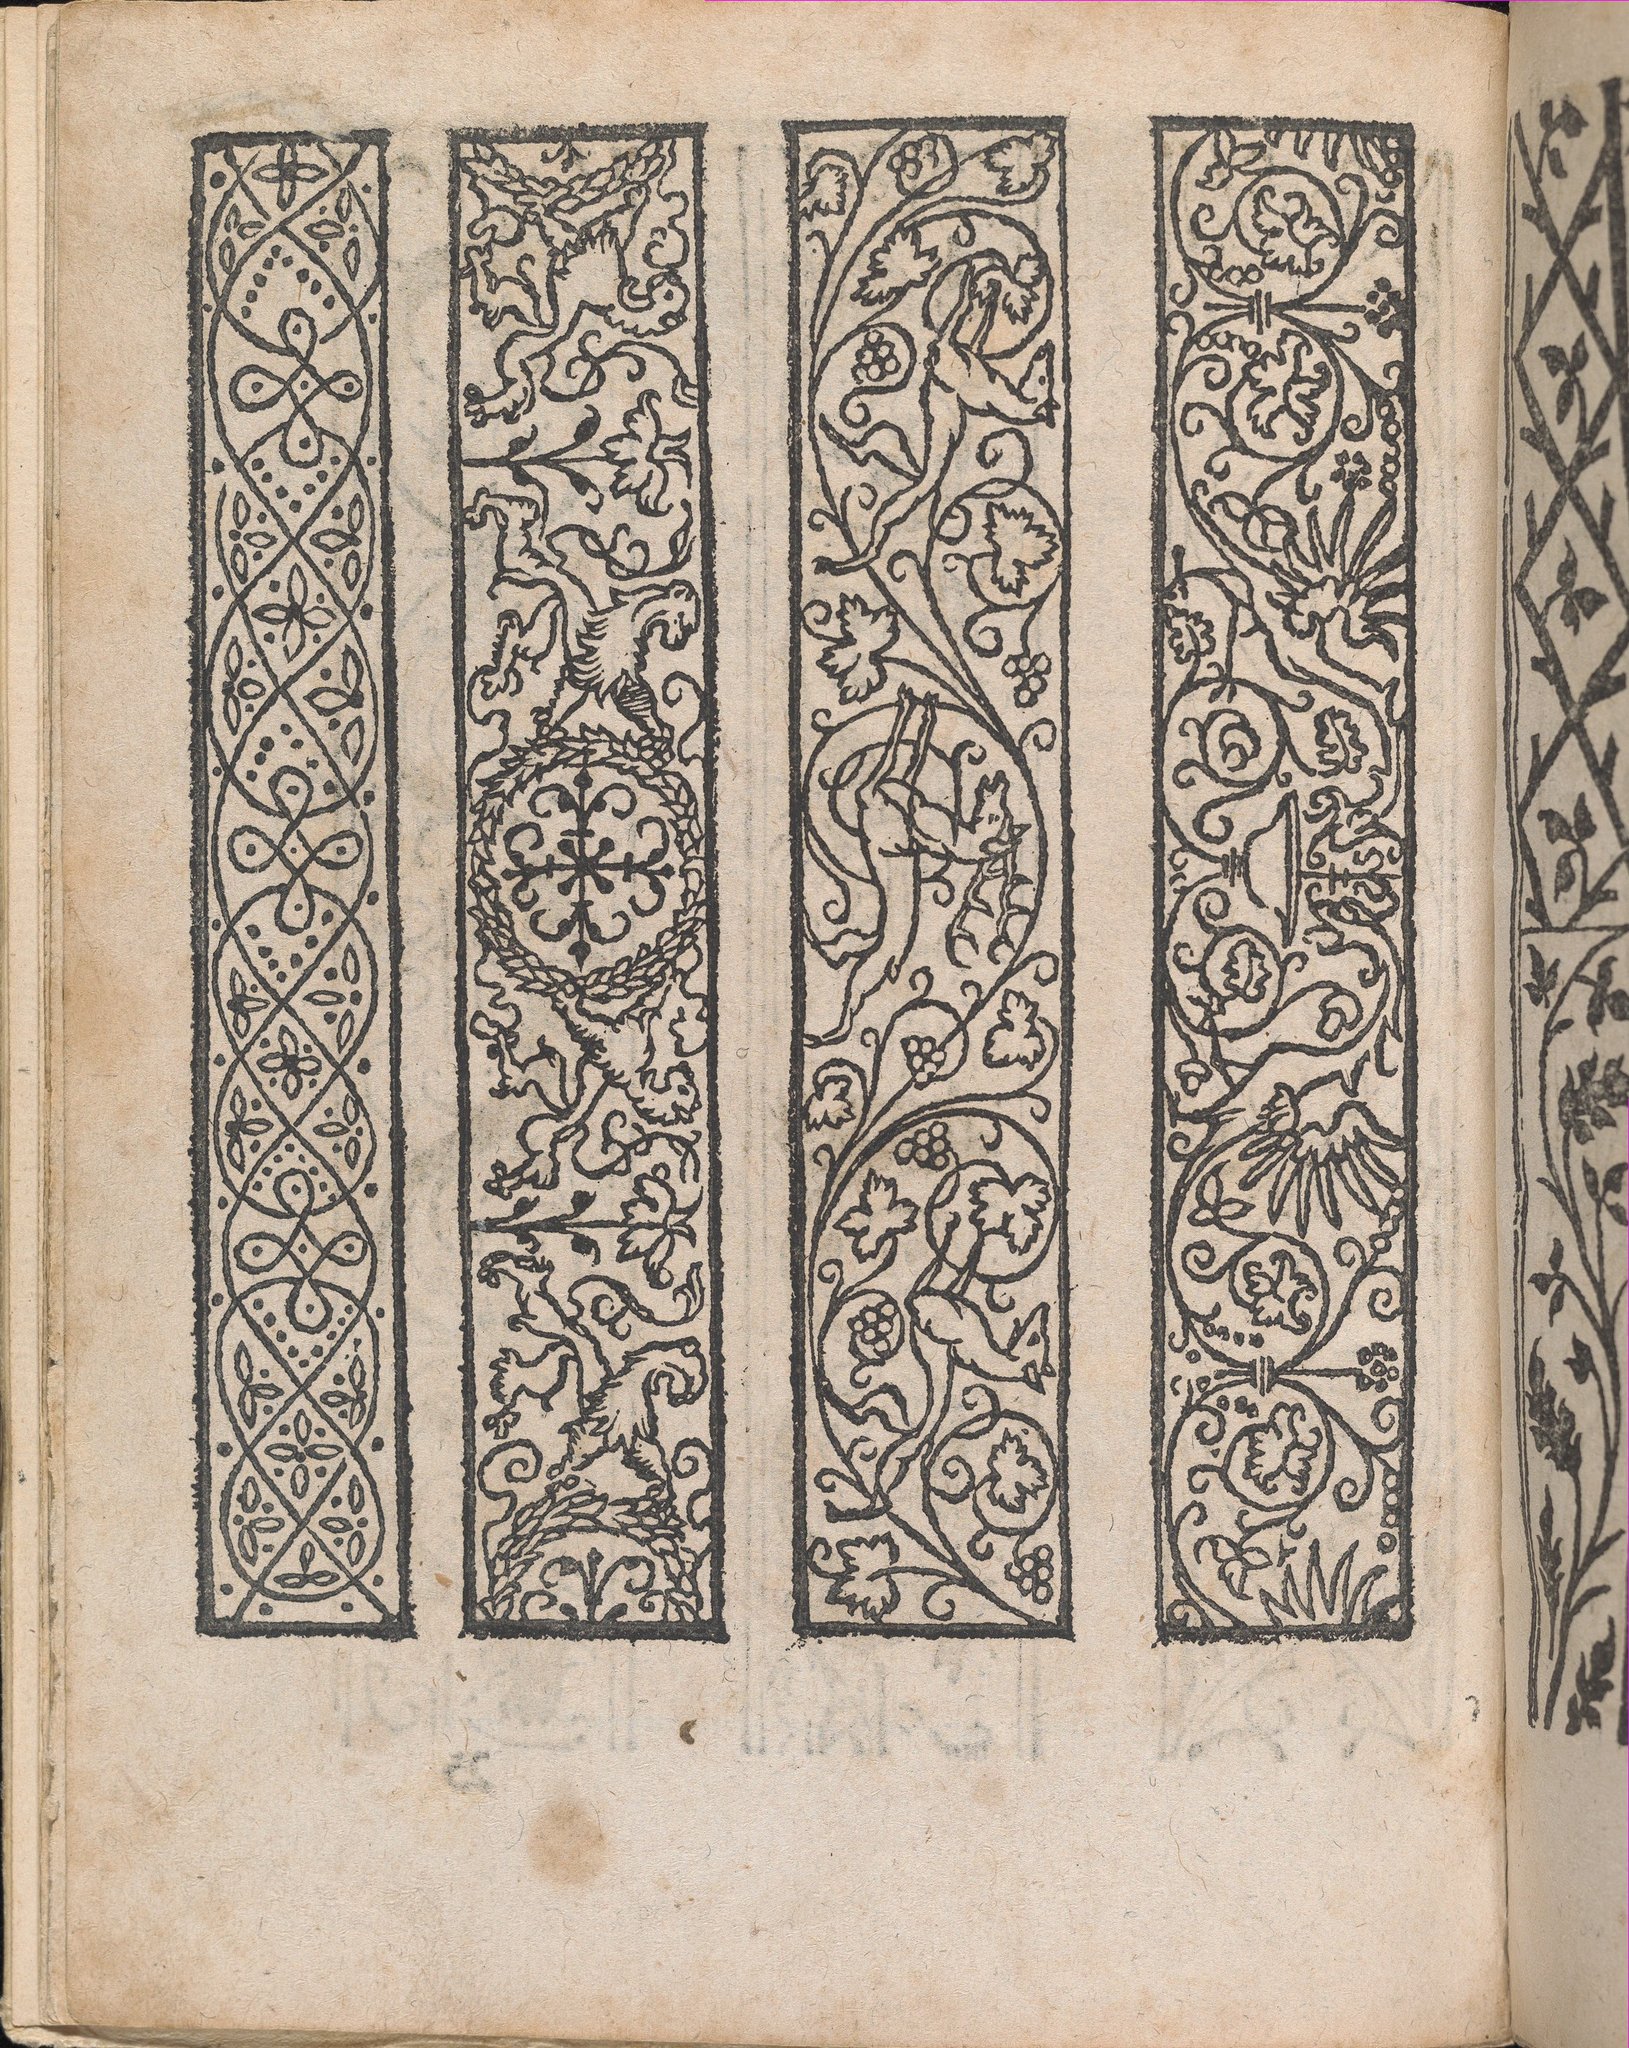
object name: book print ornament architecture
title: Modelbuch aller Art Nehens vn Stickens (Page 5v)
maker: christian egenolff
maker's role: publisher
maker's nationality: german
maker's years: 1502-1555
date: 1535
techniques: woodcut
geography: germany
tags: animals,griffins,flowers